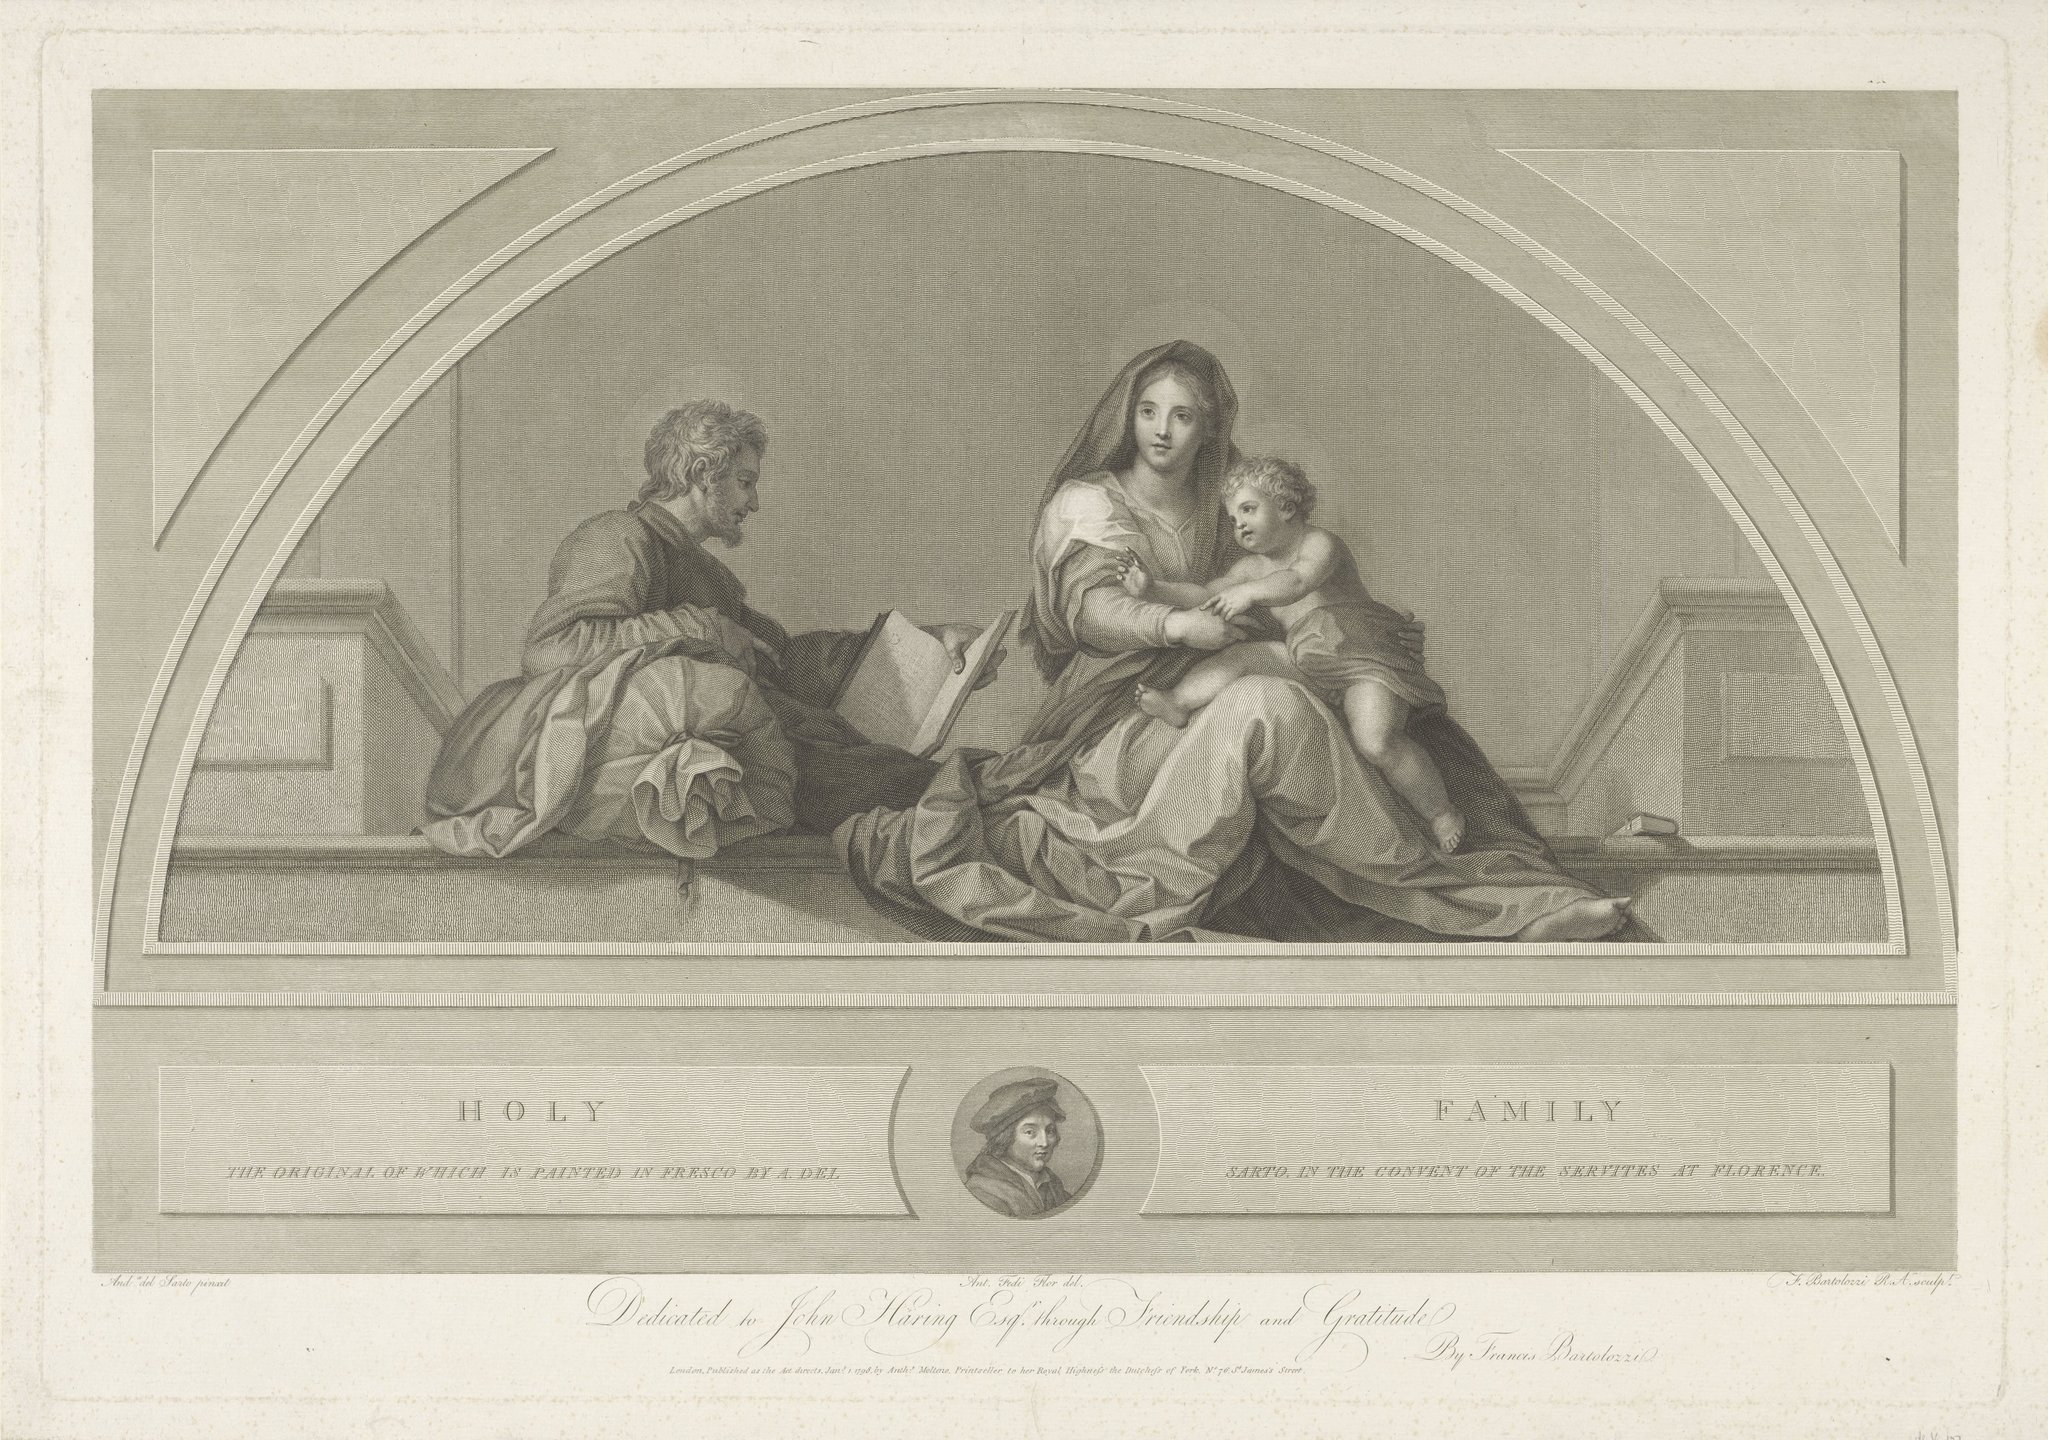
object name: print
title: Holy Family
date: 1798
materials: paper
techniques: engraving, etching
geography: florence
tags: draughtsman, andrea del sarto, holy family, and derived representations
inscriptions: collector's mark: Lugt 2165, collector's mark: Lugt 12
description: Naar een fresco door Andrea del Sarto in de Santissima Annunziata te Florence. Het fresco wordt 'Madonna del Sacco' genoemd.